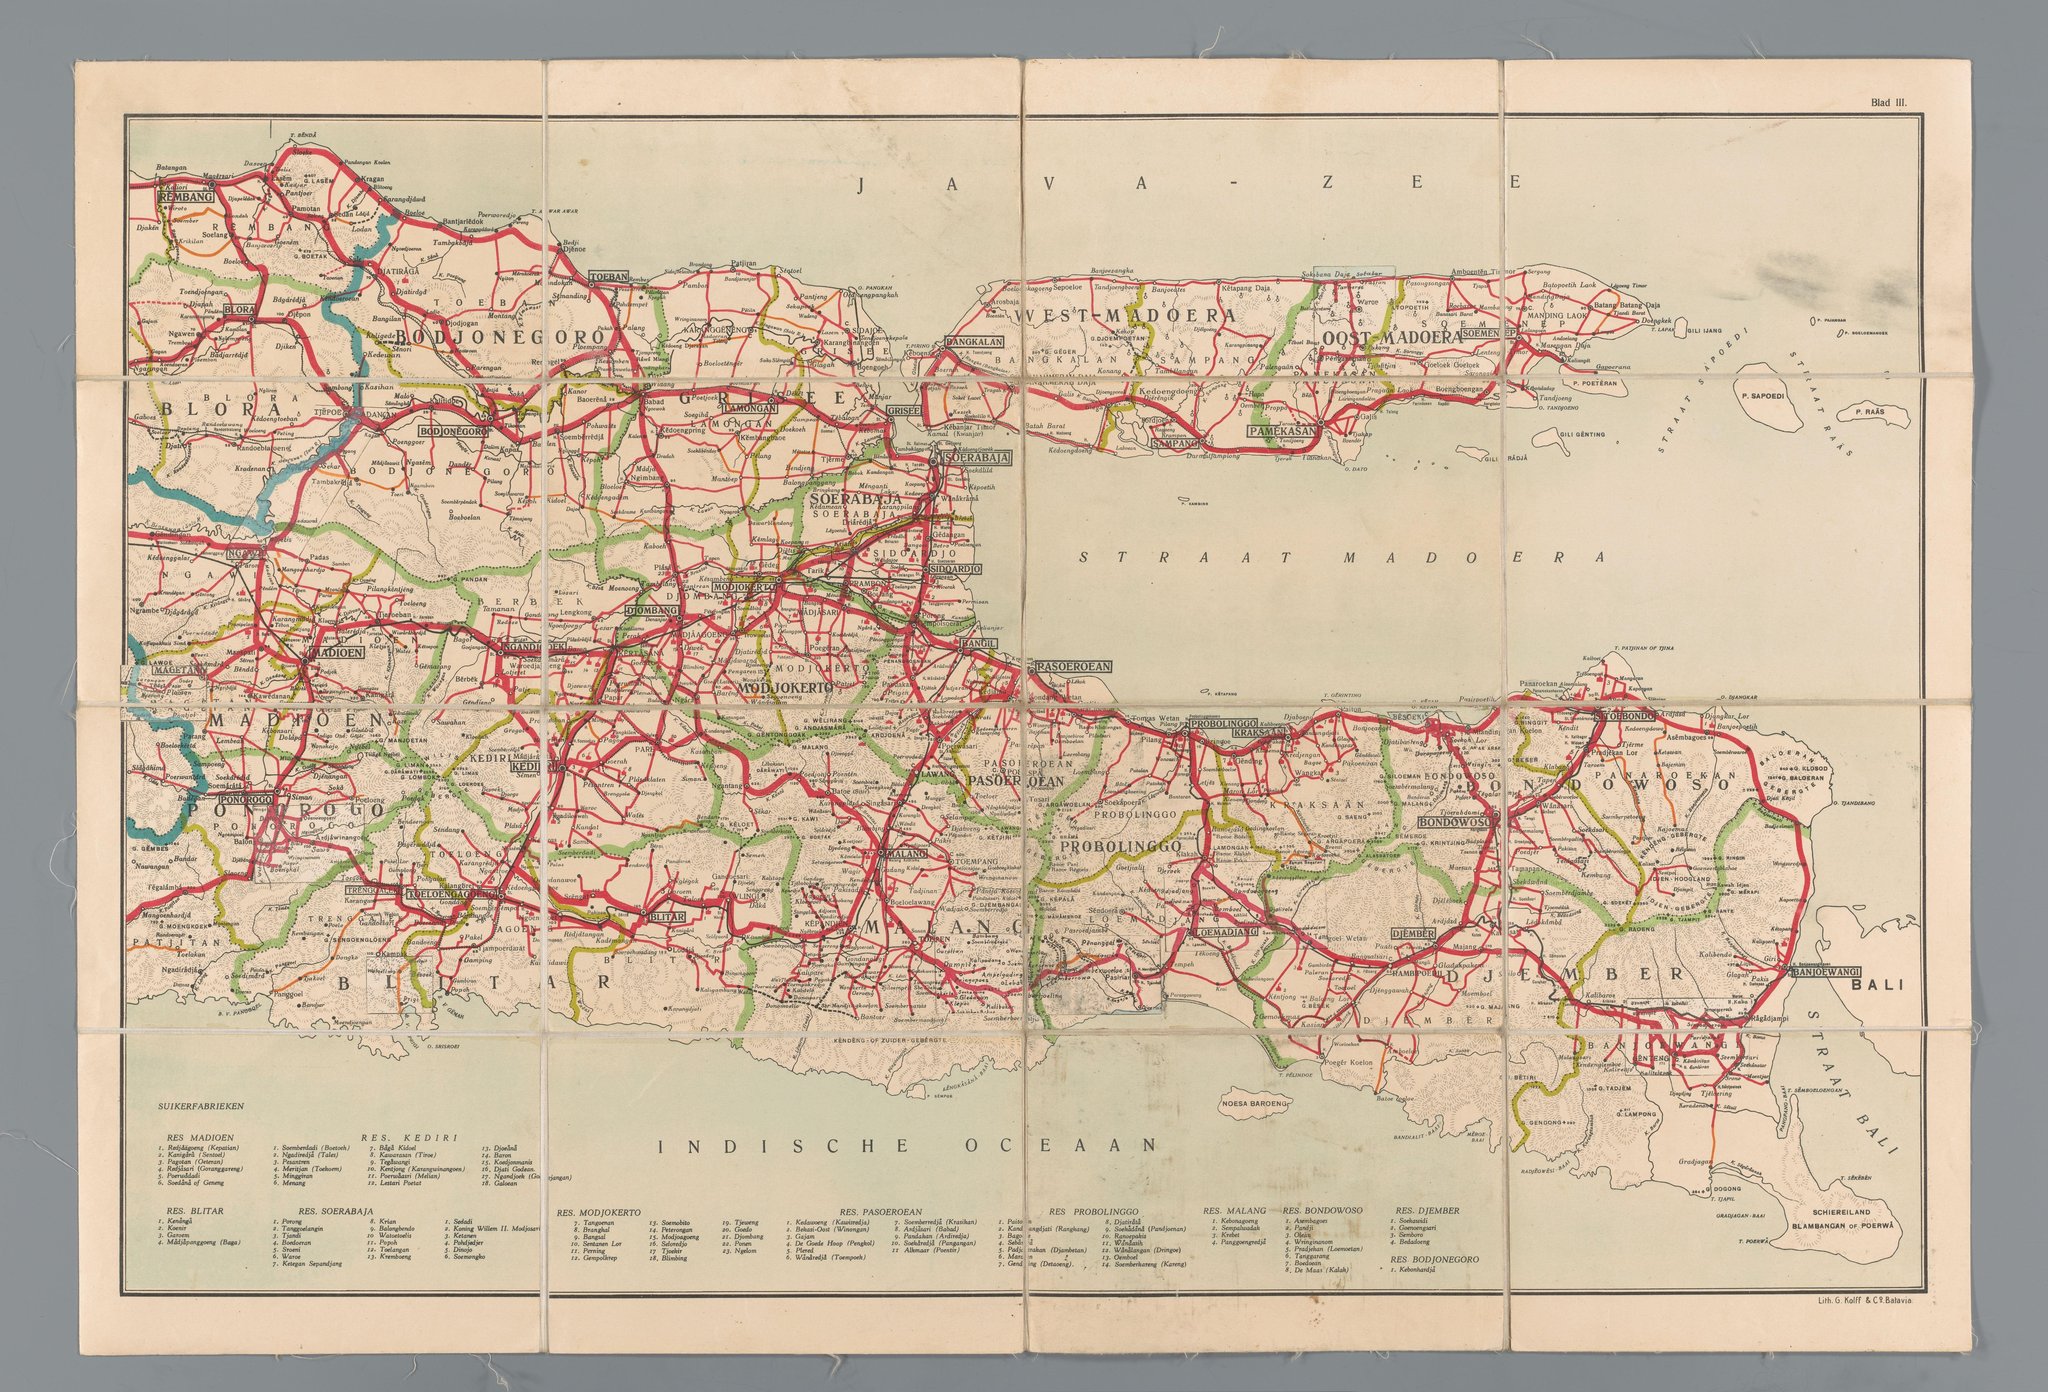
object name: print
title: Wegenkaart van Oost-Java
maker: Anonymous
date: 1906-1938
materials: linen, paper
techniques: lithograph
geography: semarang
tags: maps of separate countries or regions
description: Schaal 1:500.000. Onder de kaart een legenda van suikerfabrieken per regentschap.